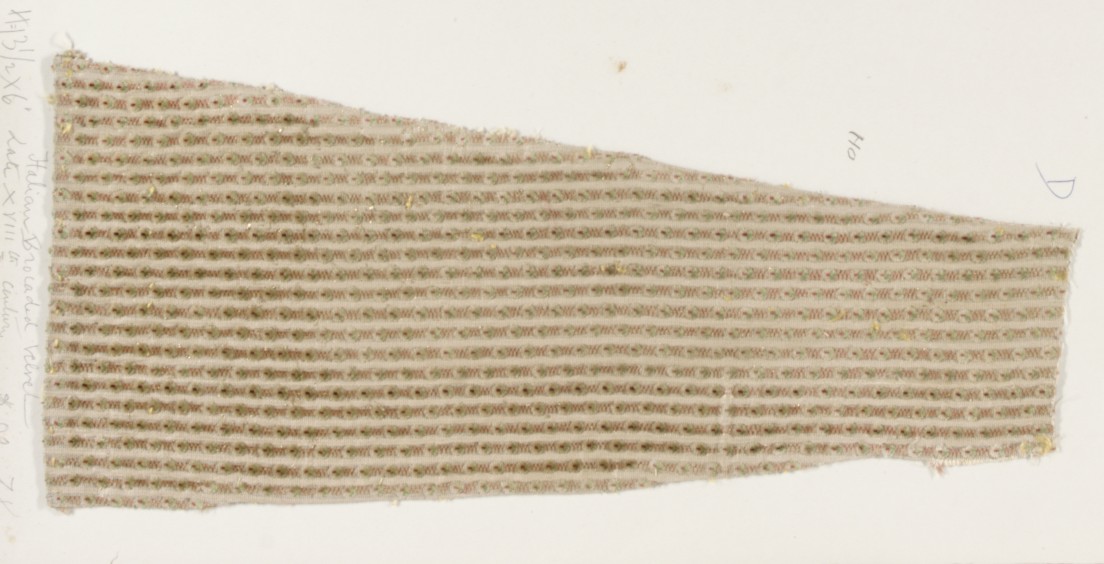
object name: fragment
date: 1767-1800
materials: metal thread, silk